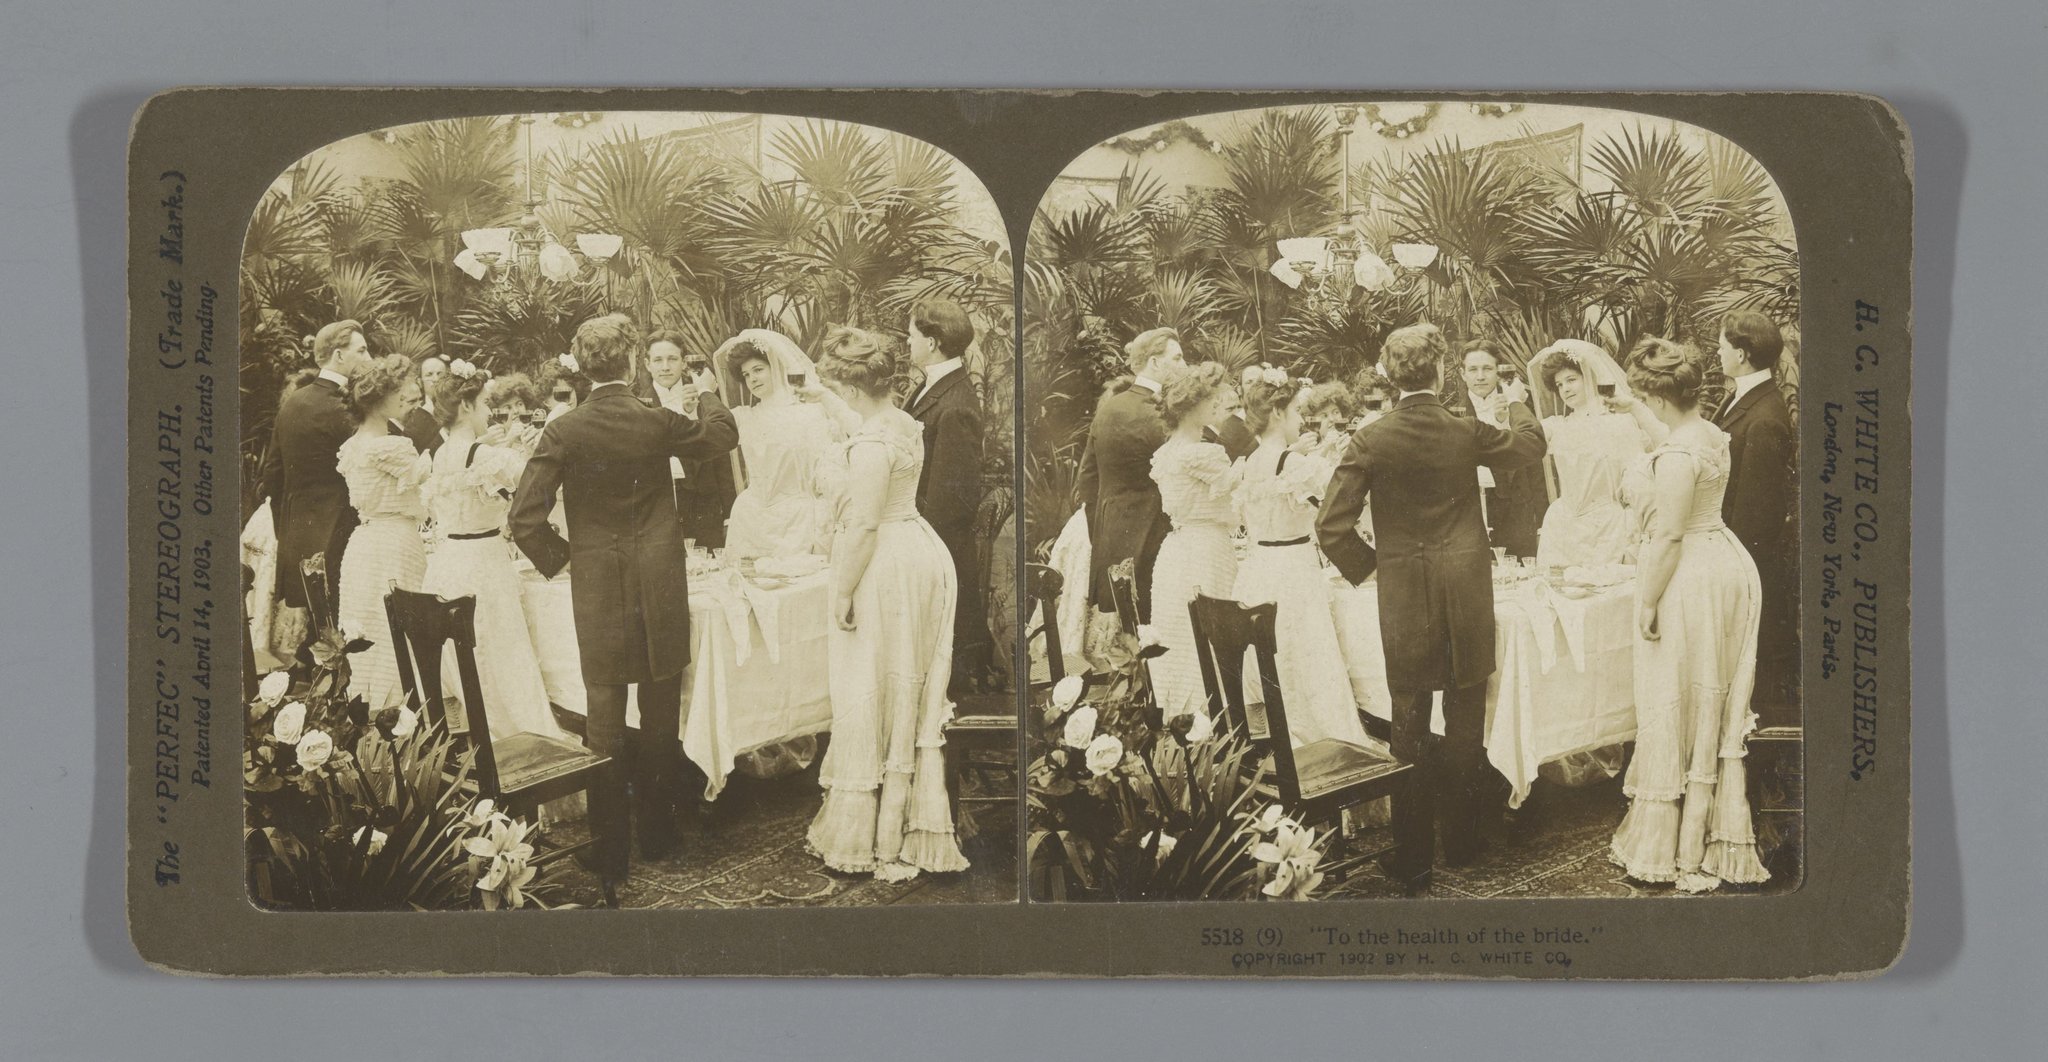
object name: stereograph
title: Groep mensen heft het glas op het bruidspaar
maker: h.c. white & co. publishers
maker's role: fotograaf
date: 1902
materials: cardboard, photographic support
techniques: gelatin silver print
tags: wedding feast, wedding meal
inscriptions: number: ‘5518’, : ‘The 'Perfec' Stereograph (Trade Mark), Patented April 14, 1903. Other Patents Pending’